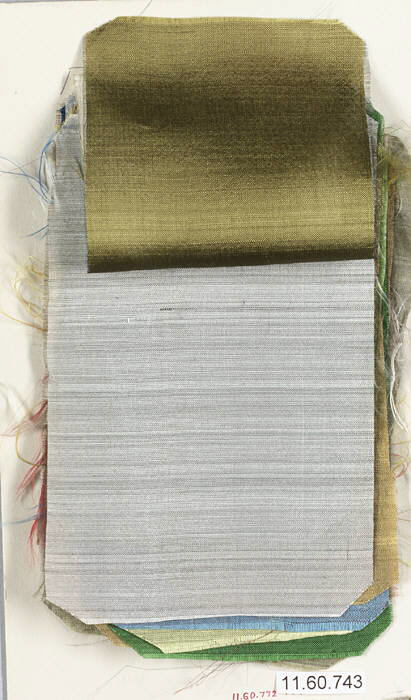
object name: sample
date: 1801-1833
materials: silk